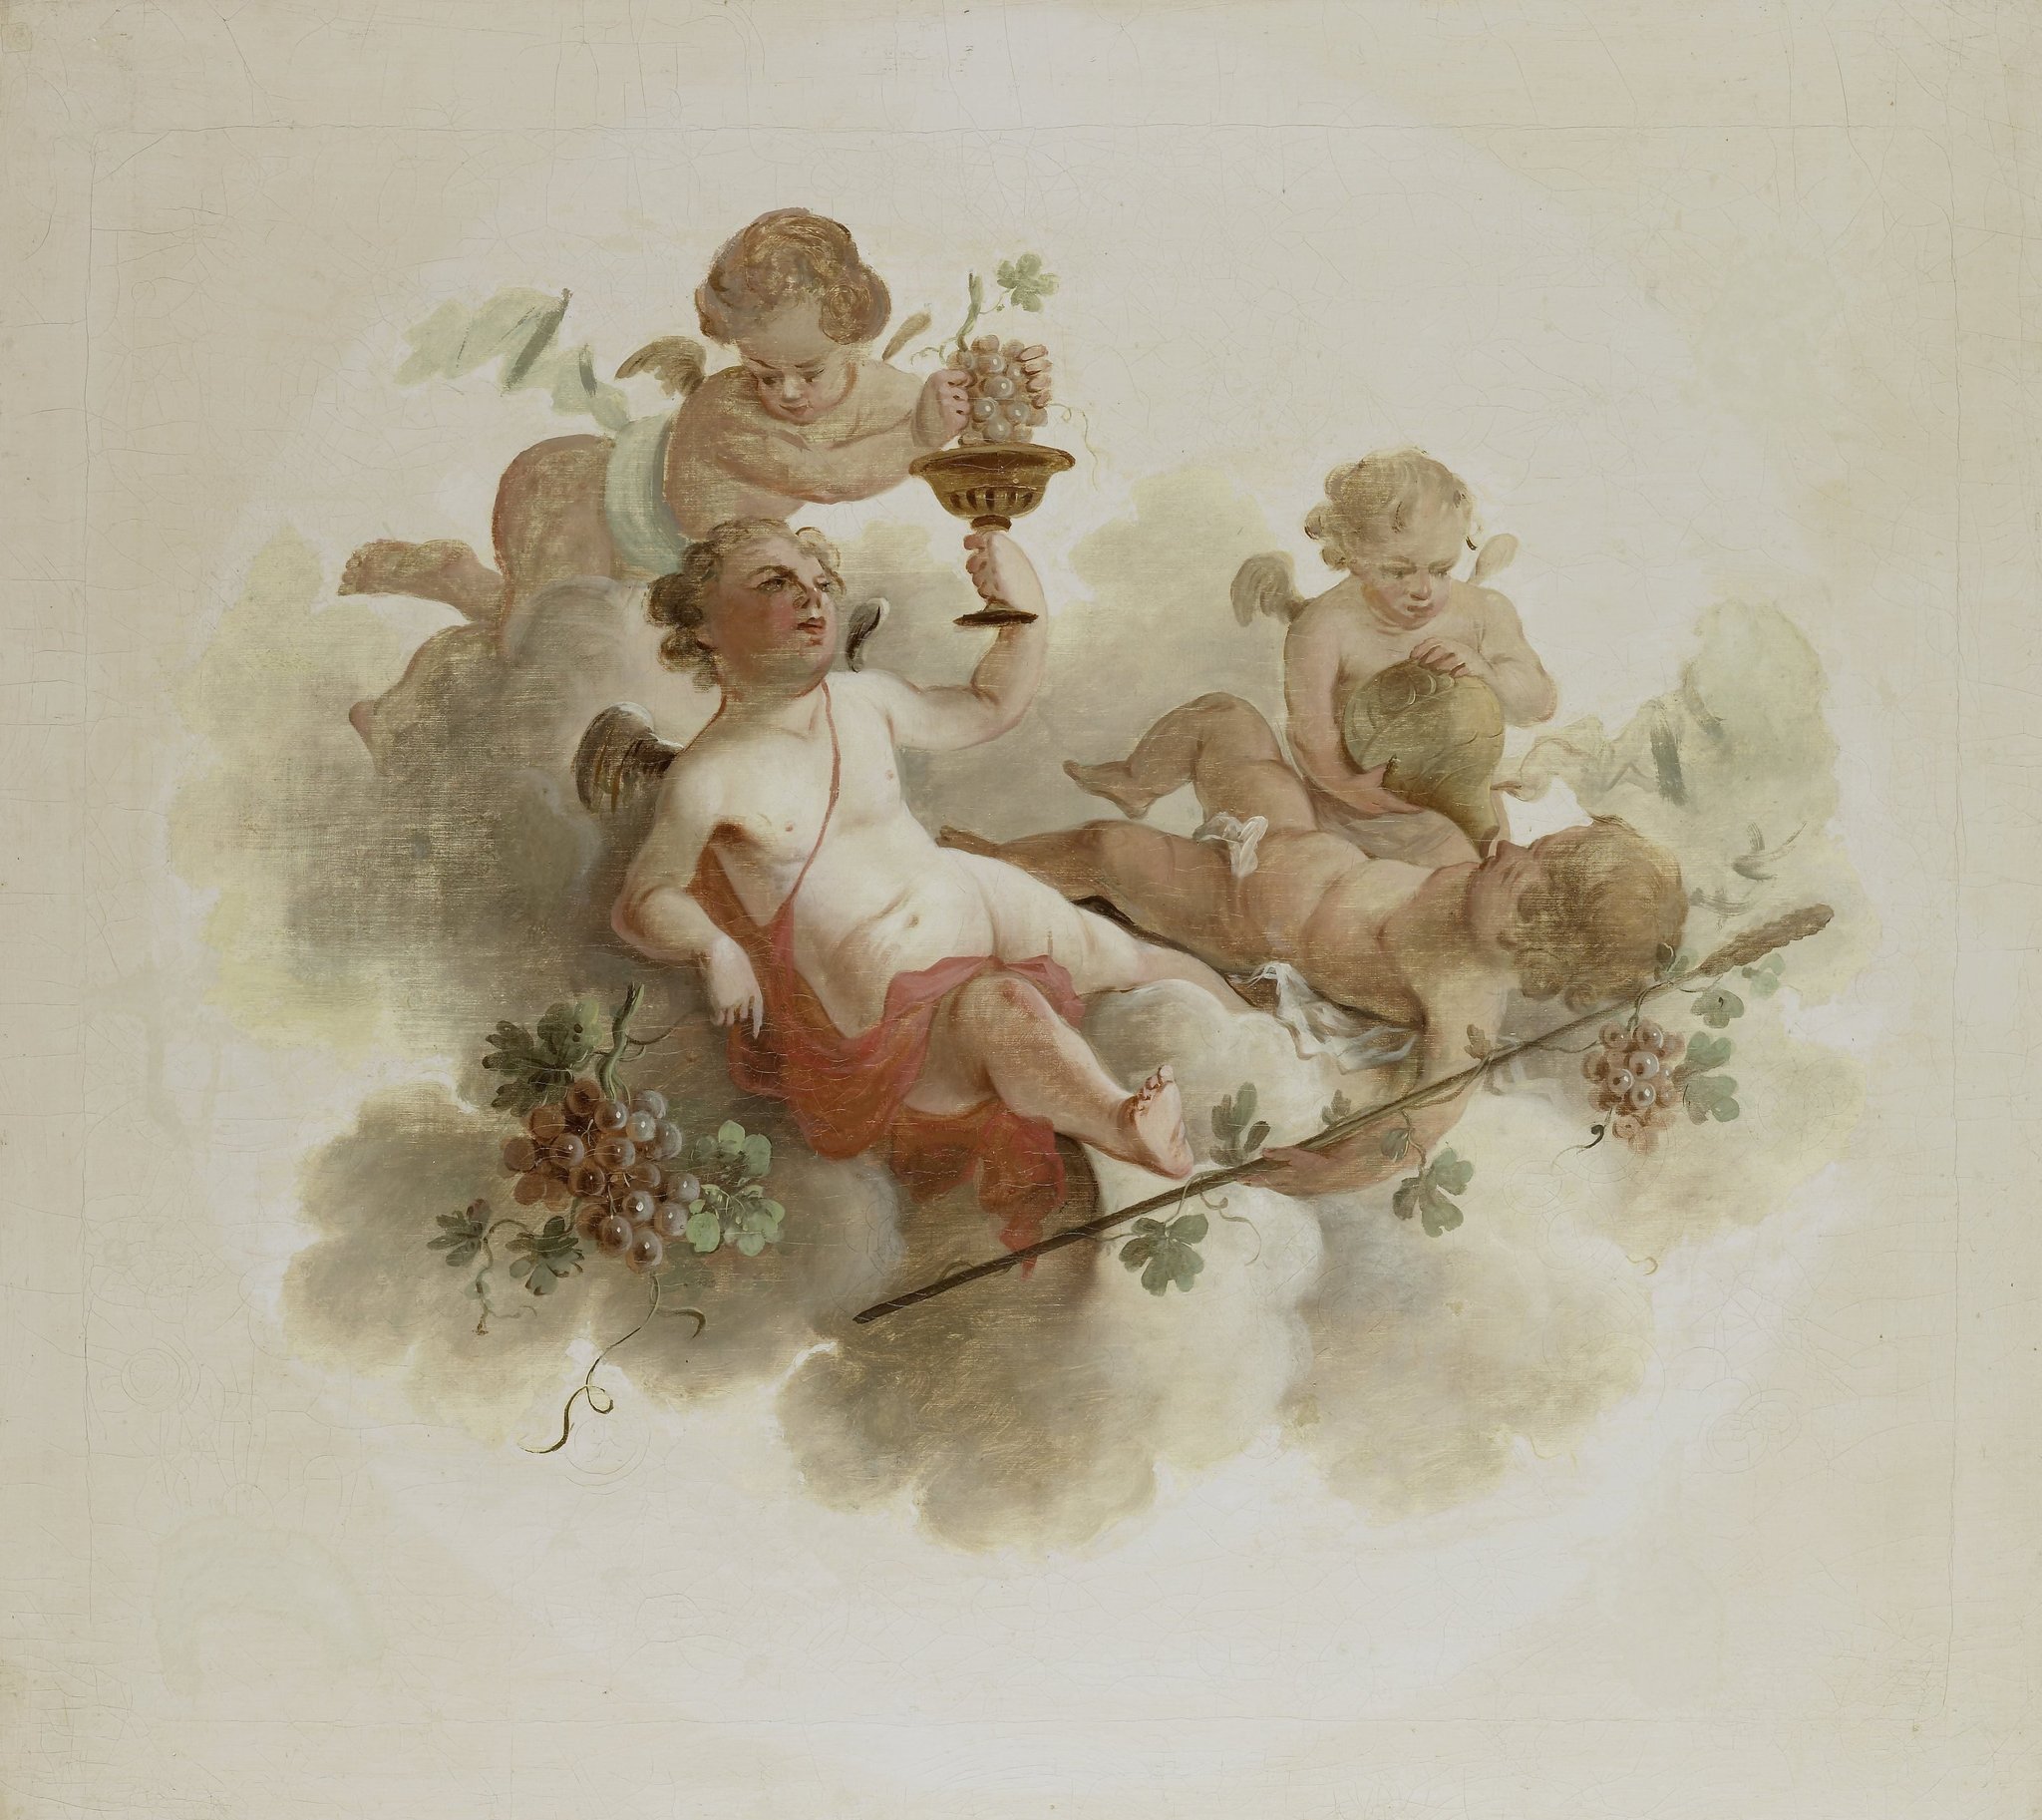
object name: painting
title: Four Putti with Grapes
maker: Anonymous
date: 1725-1774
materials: canvas, oil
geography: netherlands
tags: cupids: 'amores', 'amoretti', 'putti'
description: Vier putti die in de wolken wijn drinken en druiven in een beker uitpersen. Pendant van SK-A-2686.